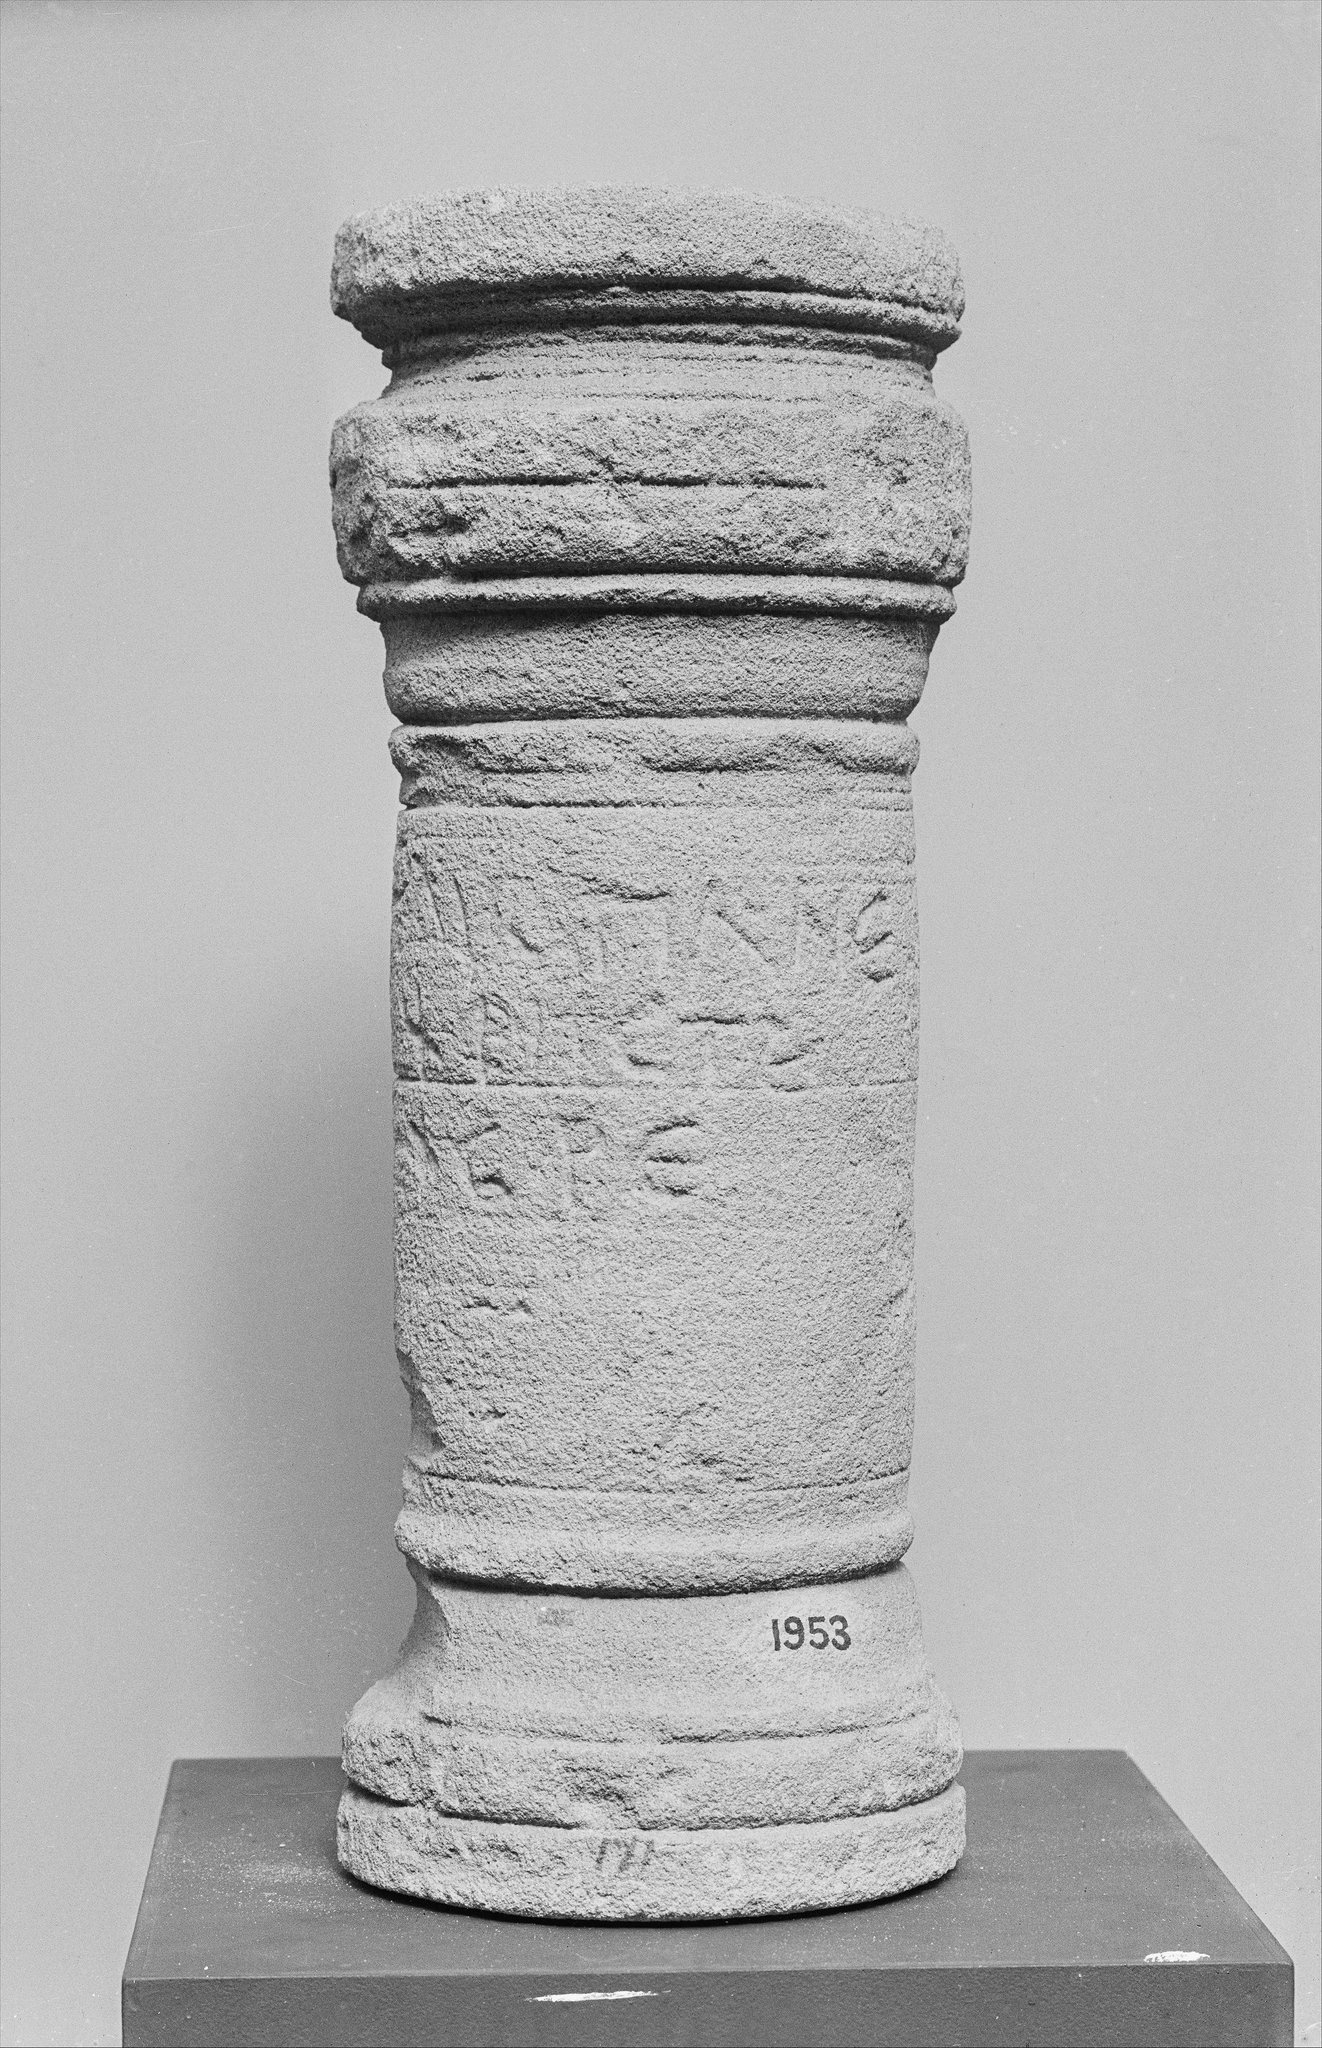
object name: cippus of olympianos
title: Limestone cippus of Olympianos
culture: roman, cypriot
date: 101-300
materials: limestone